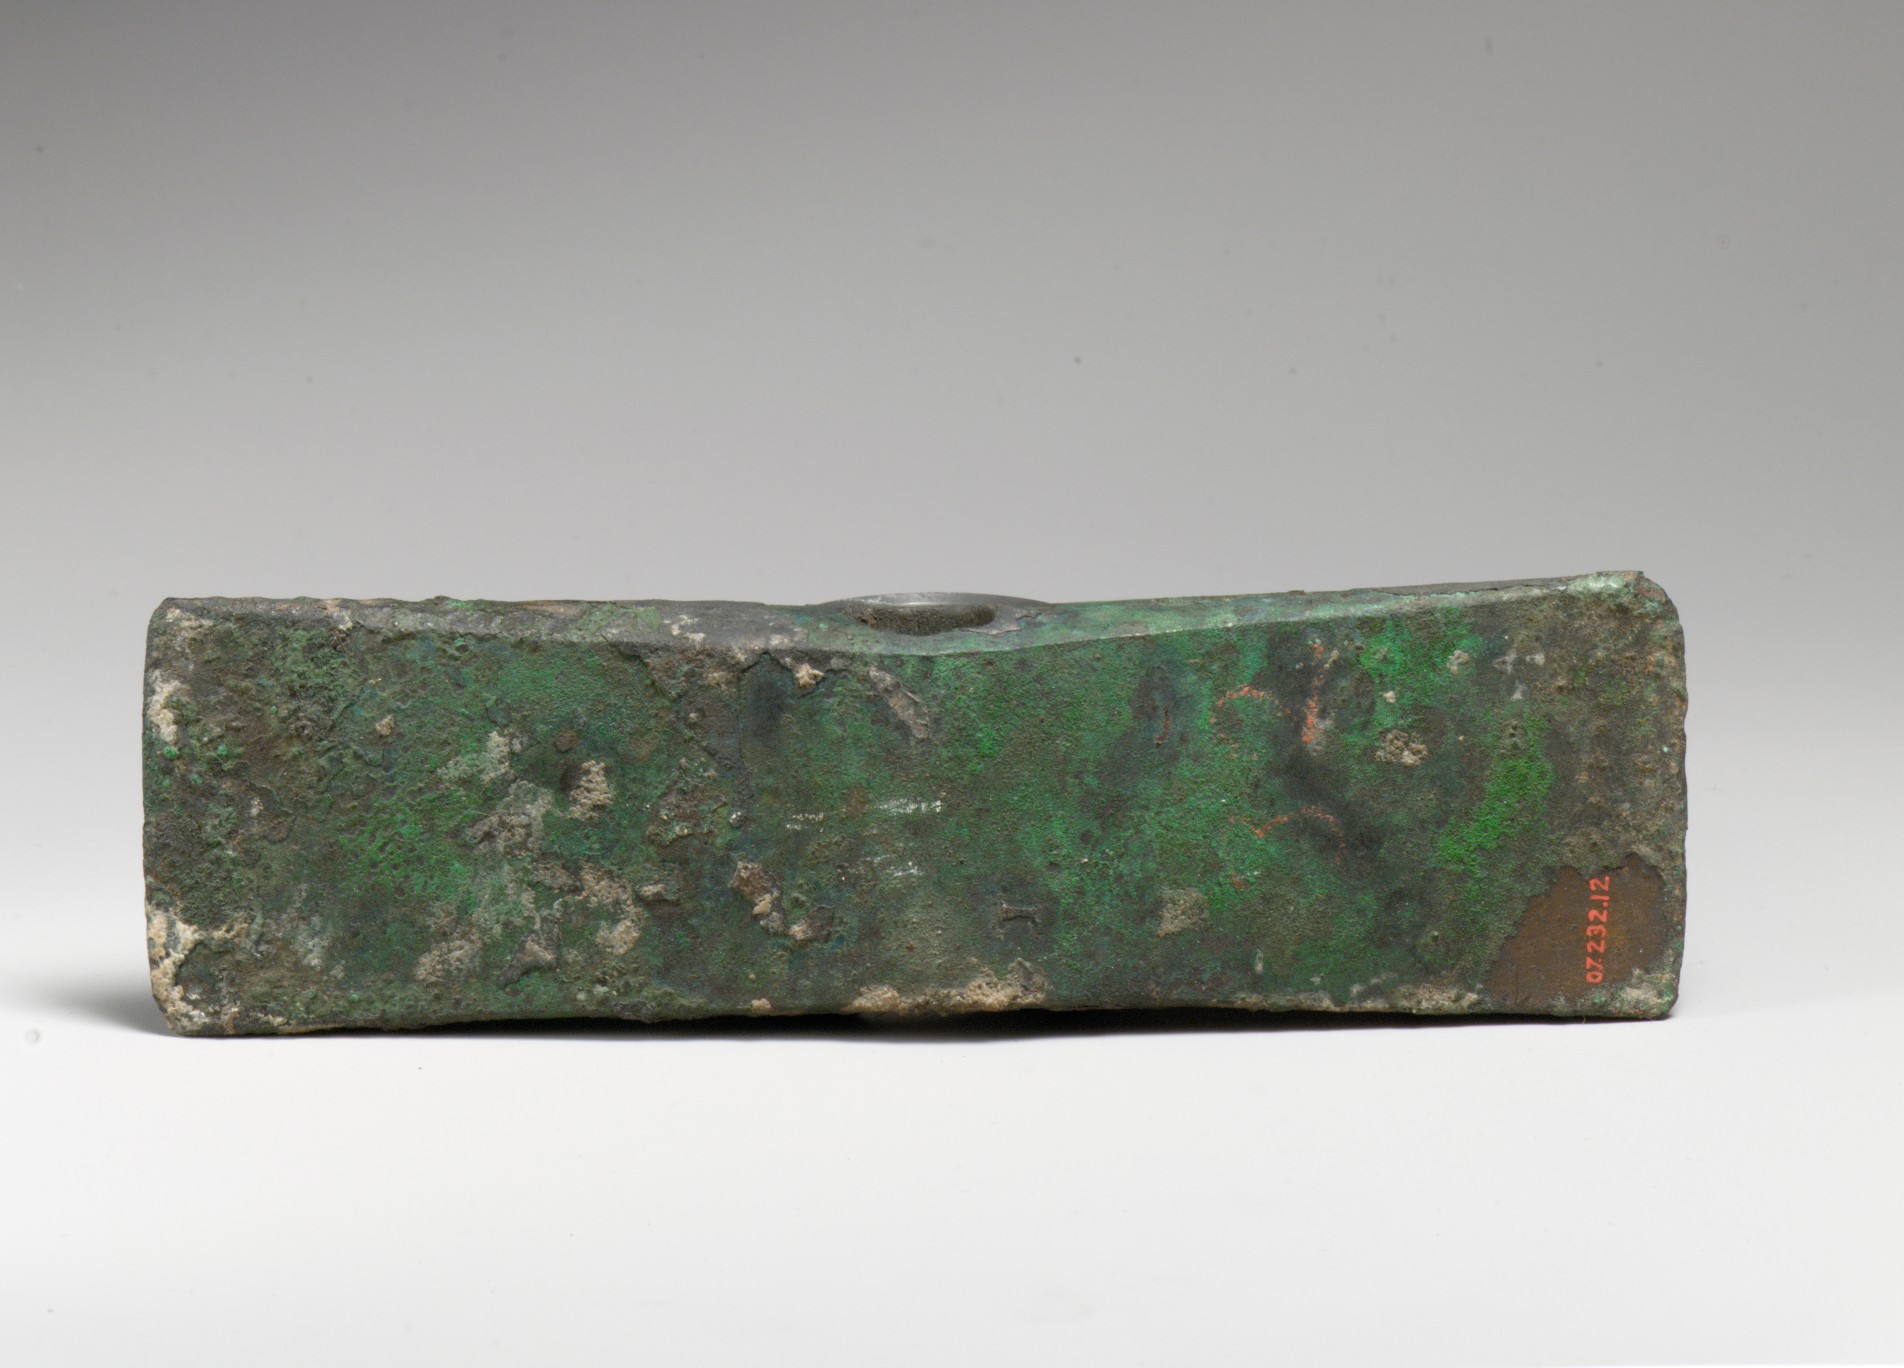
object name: axehead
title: Bronze double axe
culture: minoan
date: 1600-1450 BCE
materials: bronze